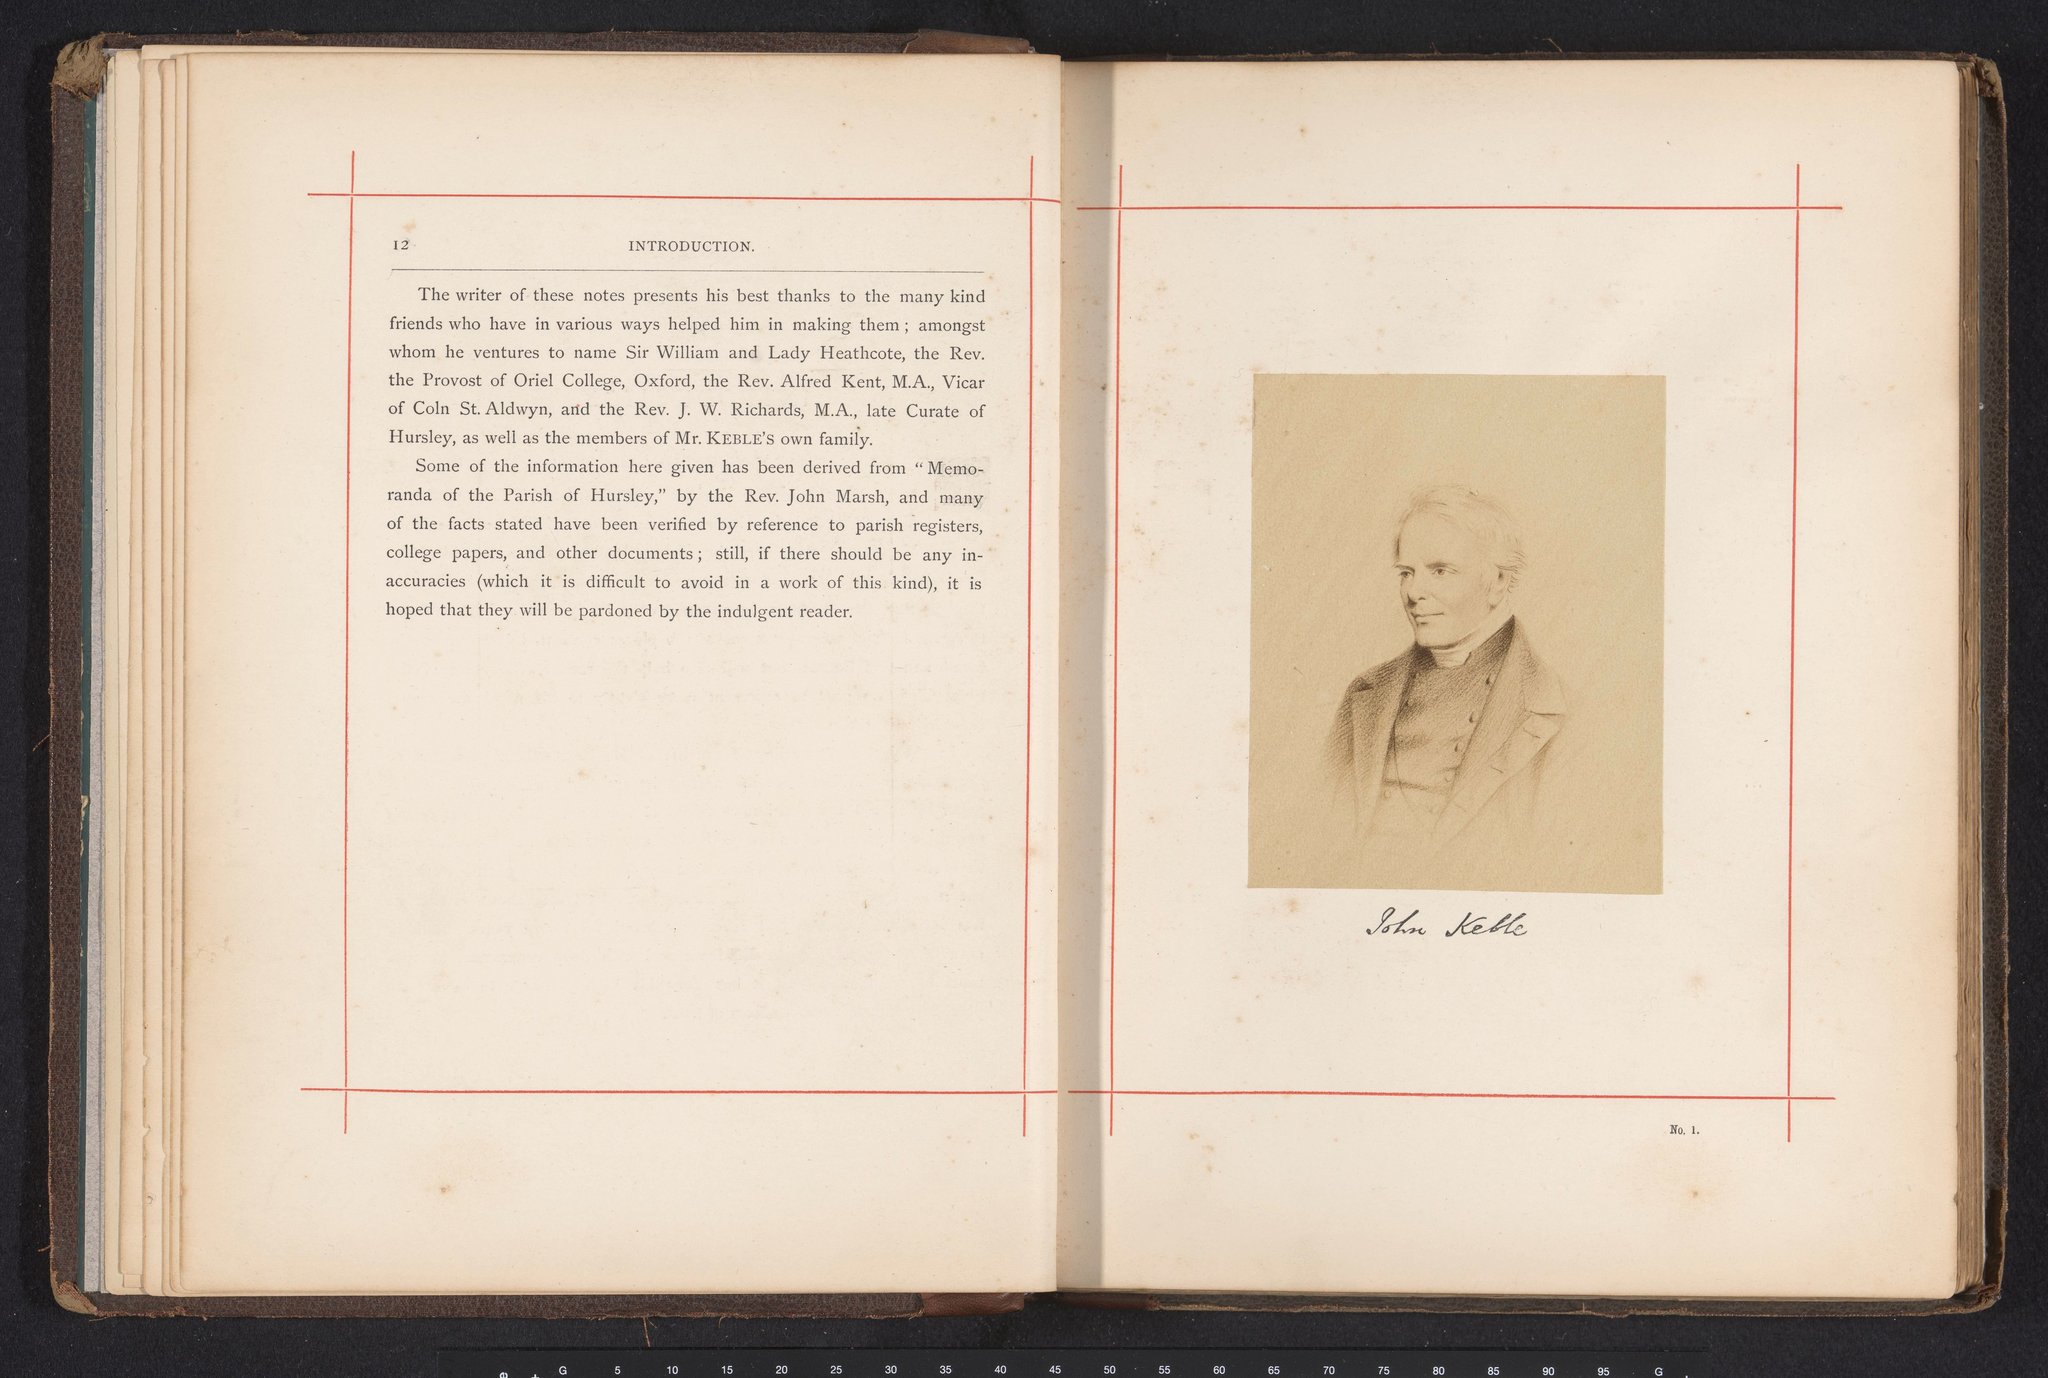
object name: photograph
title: Fotoreproductie van een getekend portret van John Keble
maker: william savage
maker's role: fotograaf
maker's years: 1817-1887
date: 1861-1866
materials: paper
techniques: albumen print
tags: john keble, writer, poet, author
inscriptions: number: ‘No. 1.’